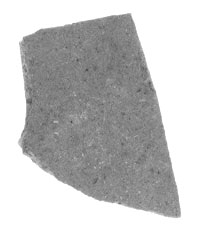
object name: shard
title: Shard (Study Collection)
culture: chinese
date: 1644-1911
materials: ceramic, glaze